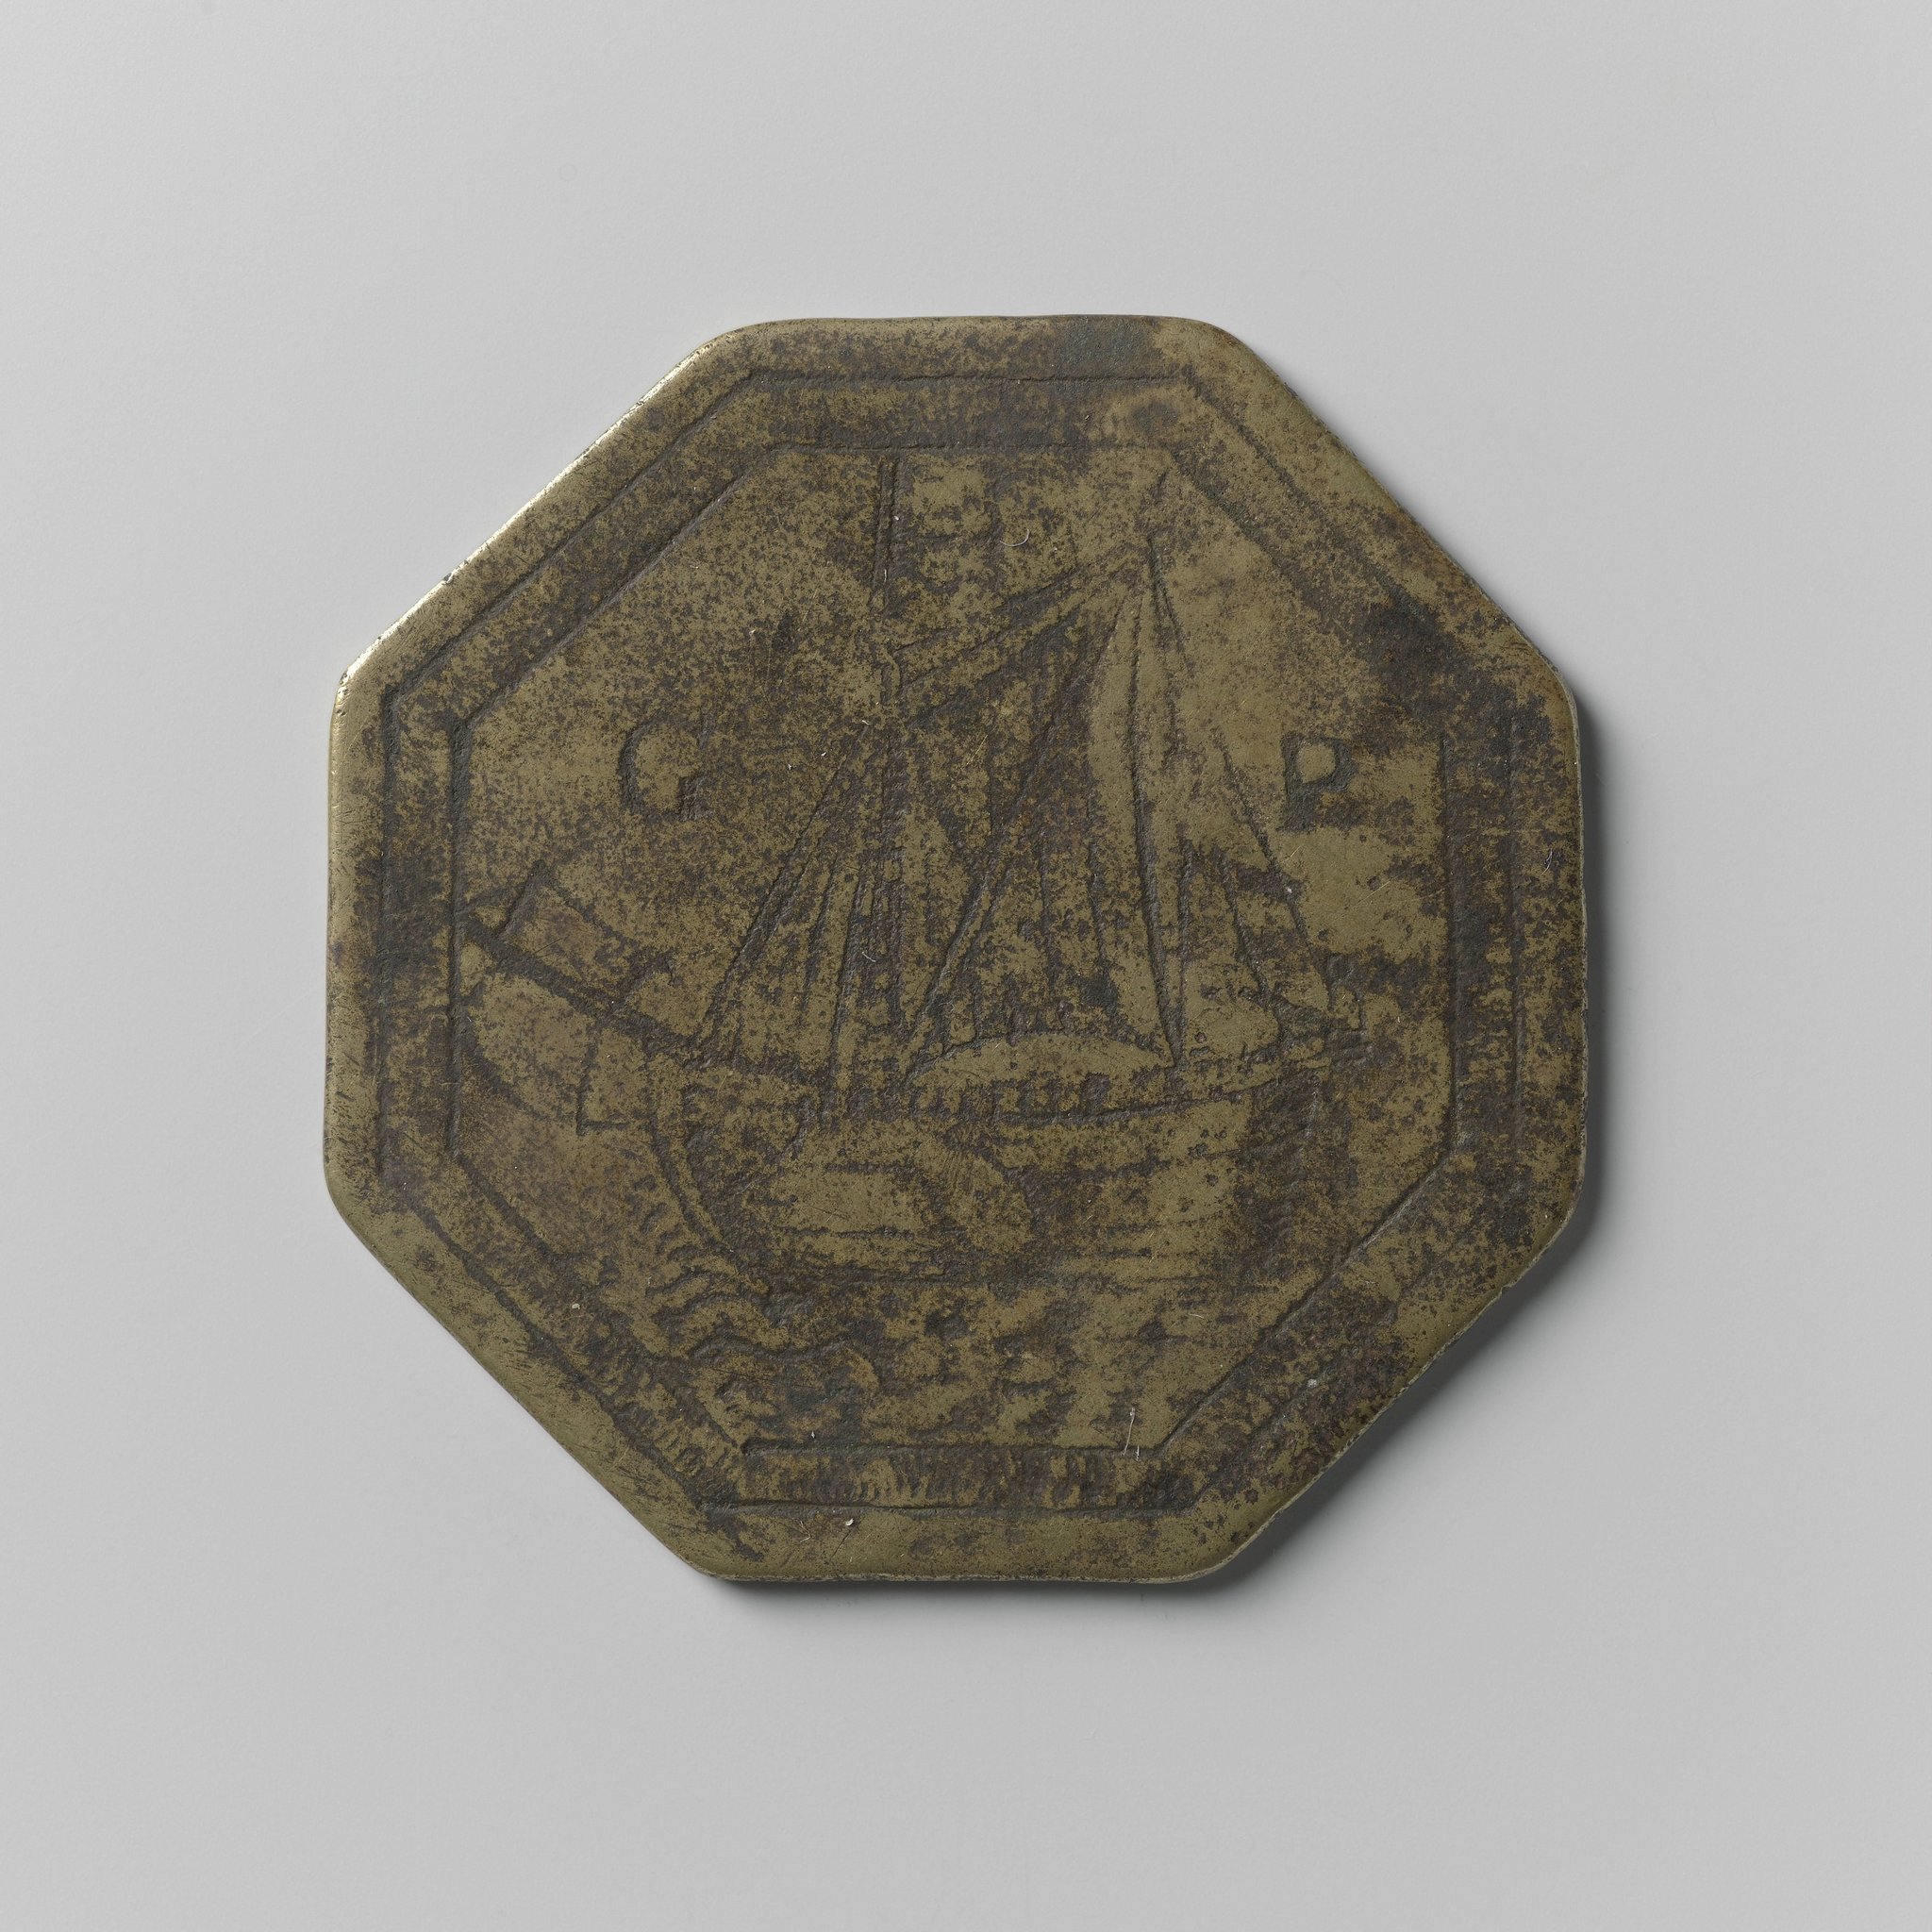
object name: medal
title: Groot schippersgilde van Franeker, gildepenning van Beern Jansen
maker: Anonymous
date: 1645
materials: brass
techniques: engraving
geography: franeker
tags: beern jansen, franeker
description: Messing achthoekige penning. Voorzijde: naar links varend schip tussen letters G en P binnen kabelrand. Keerzijde: wapenschild boven opschrift binnen kabelrand